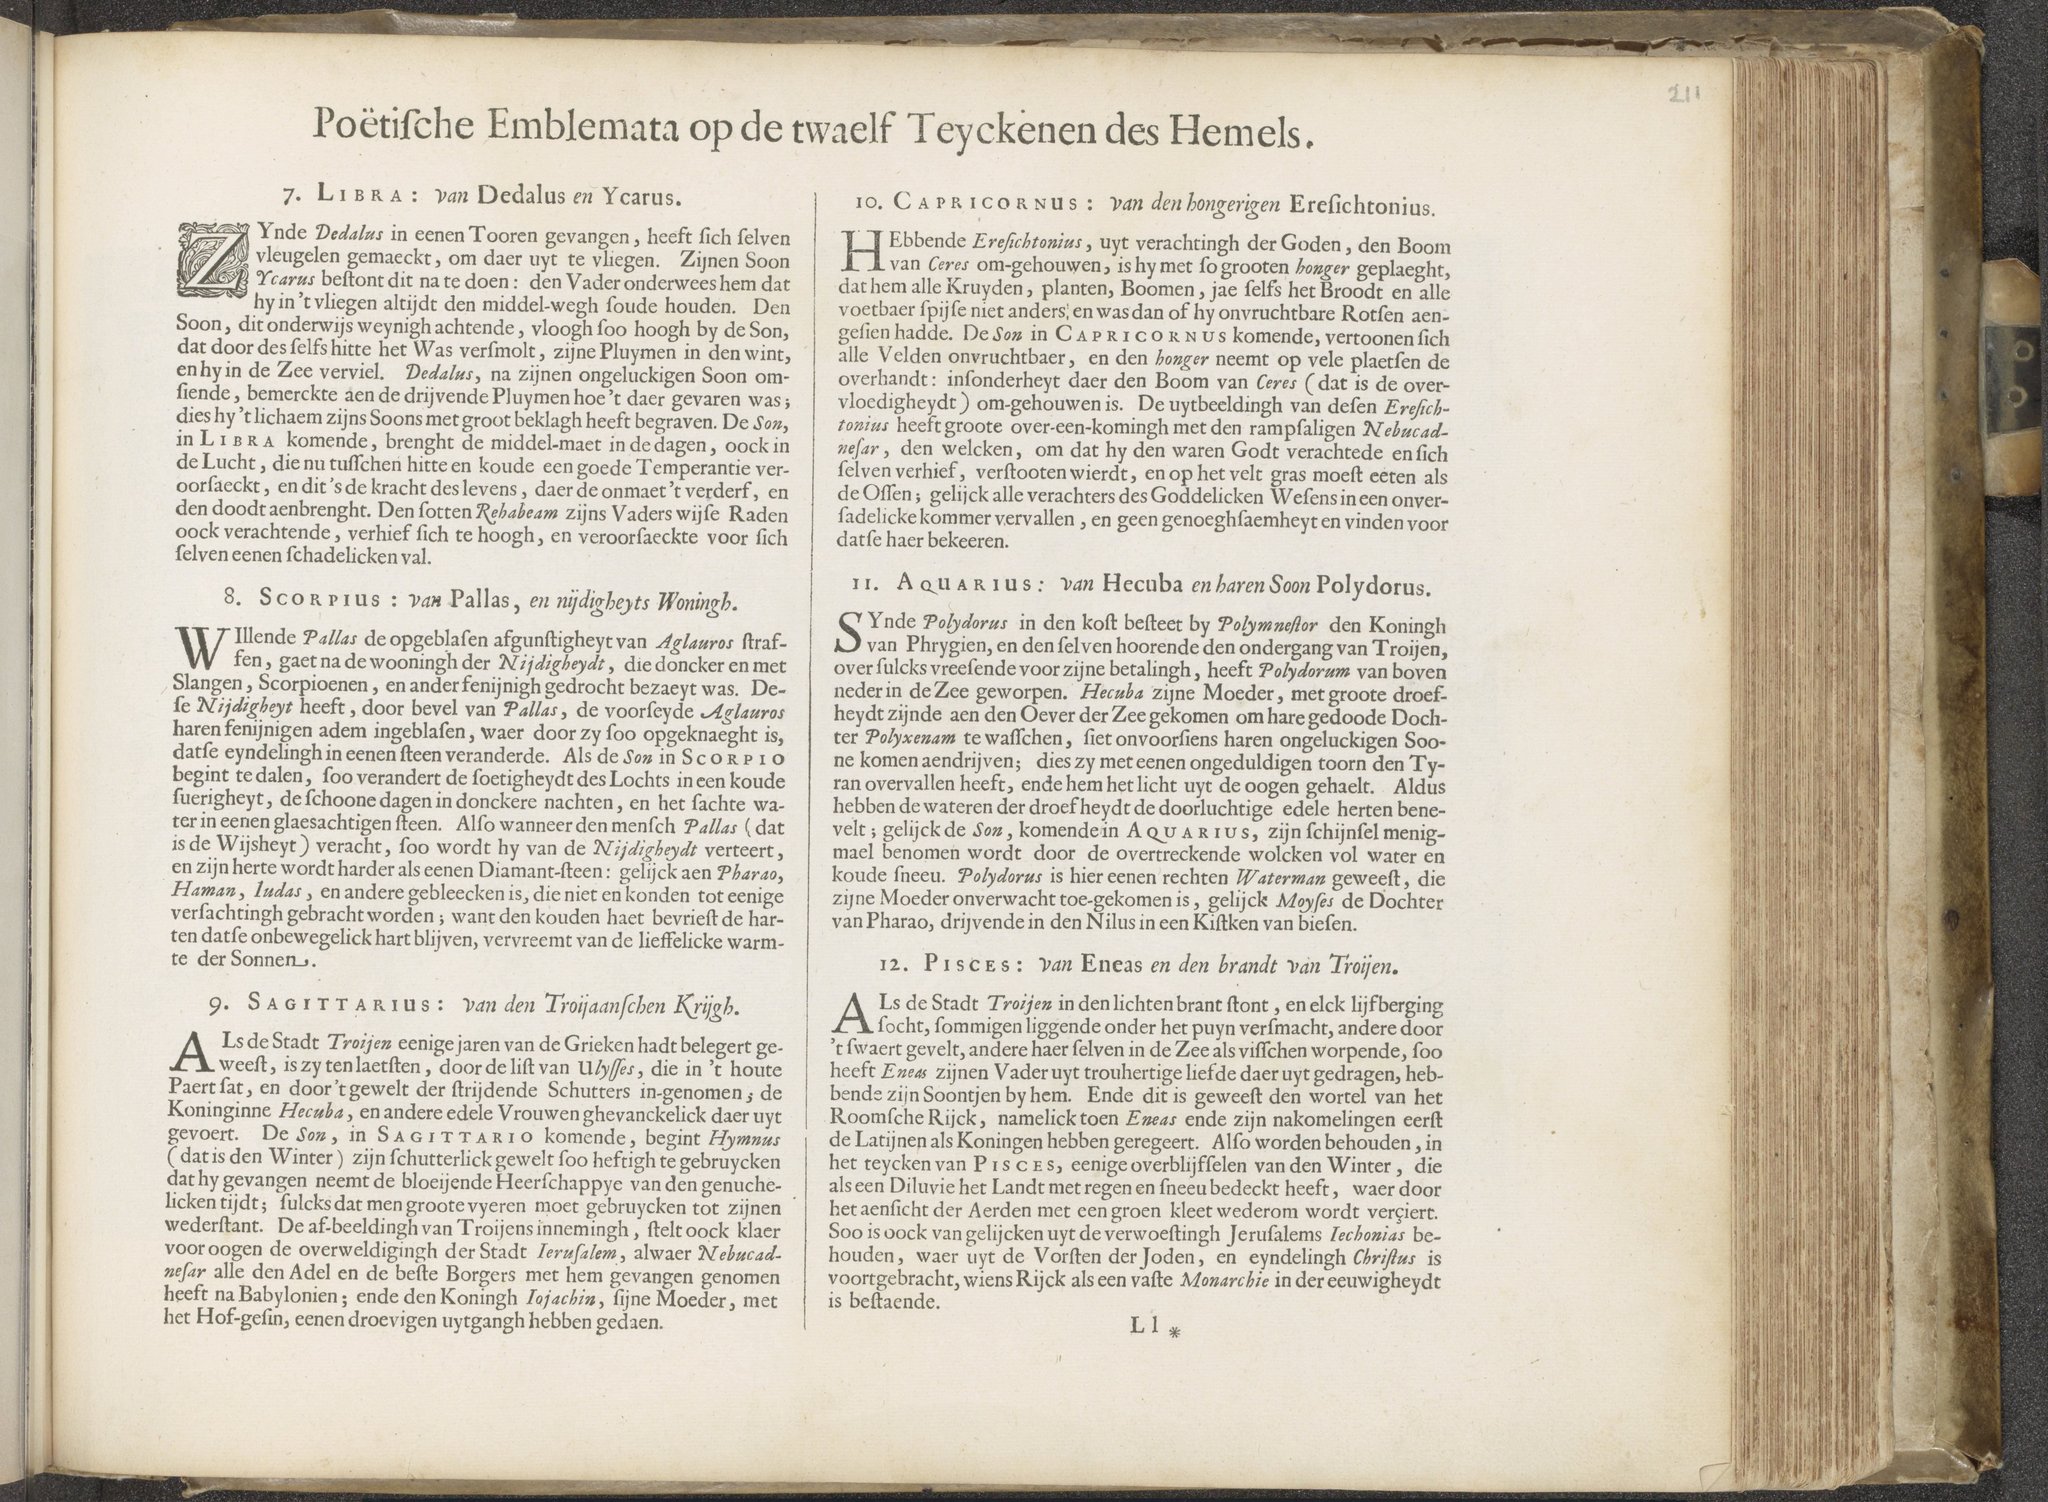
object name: album leaf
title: Poëtische emblemata op de twaelf teyckenen des hemels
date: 1653-1654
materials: paper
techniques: letterpress printing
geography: amsterdam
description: Toelichtingen bij de tweede zes tekens van de dierenriem (september - februari): Libra (Weegschaal), Scorpio (Schorpioen), Sagittarius (Boogschutter), Capricorn (Steenbok), Aquarius (Waterman), Pisces (Vissen). De tekst vangt aan met een kleine gedecoreerde initiaal Z. Het blad maakt deel uit van een album.